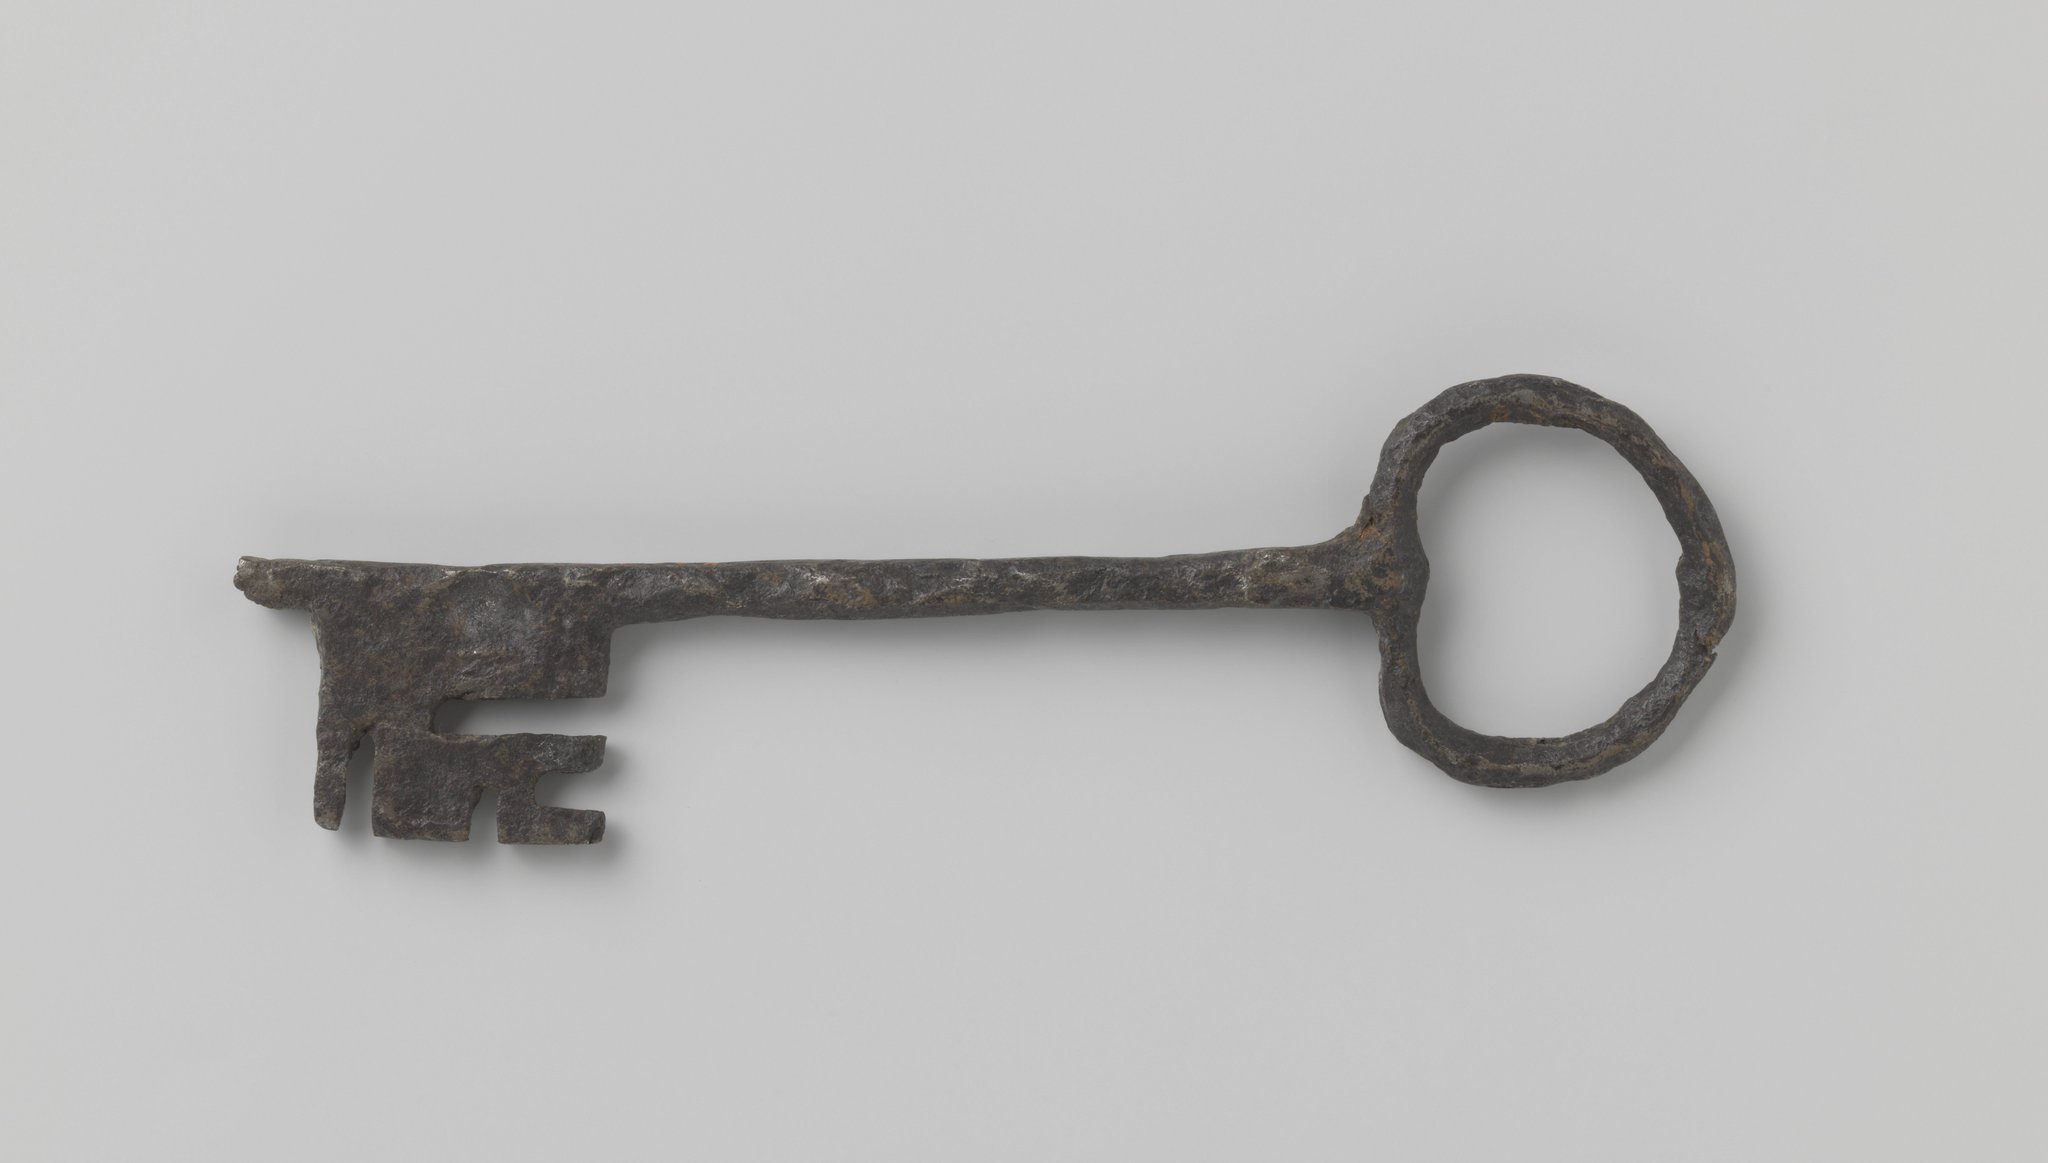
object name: key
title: Sleutel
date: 1300-1500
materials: iron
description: Sleutel met boonvormig oog en vierzijdige schacht, die voorbij de baard eindigt.